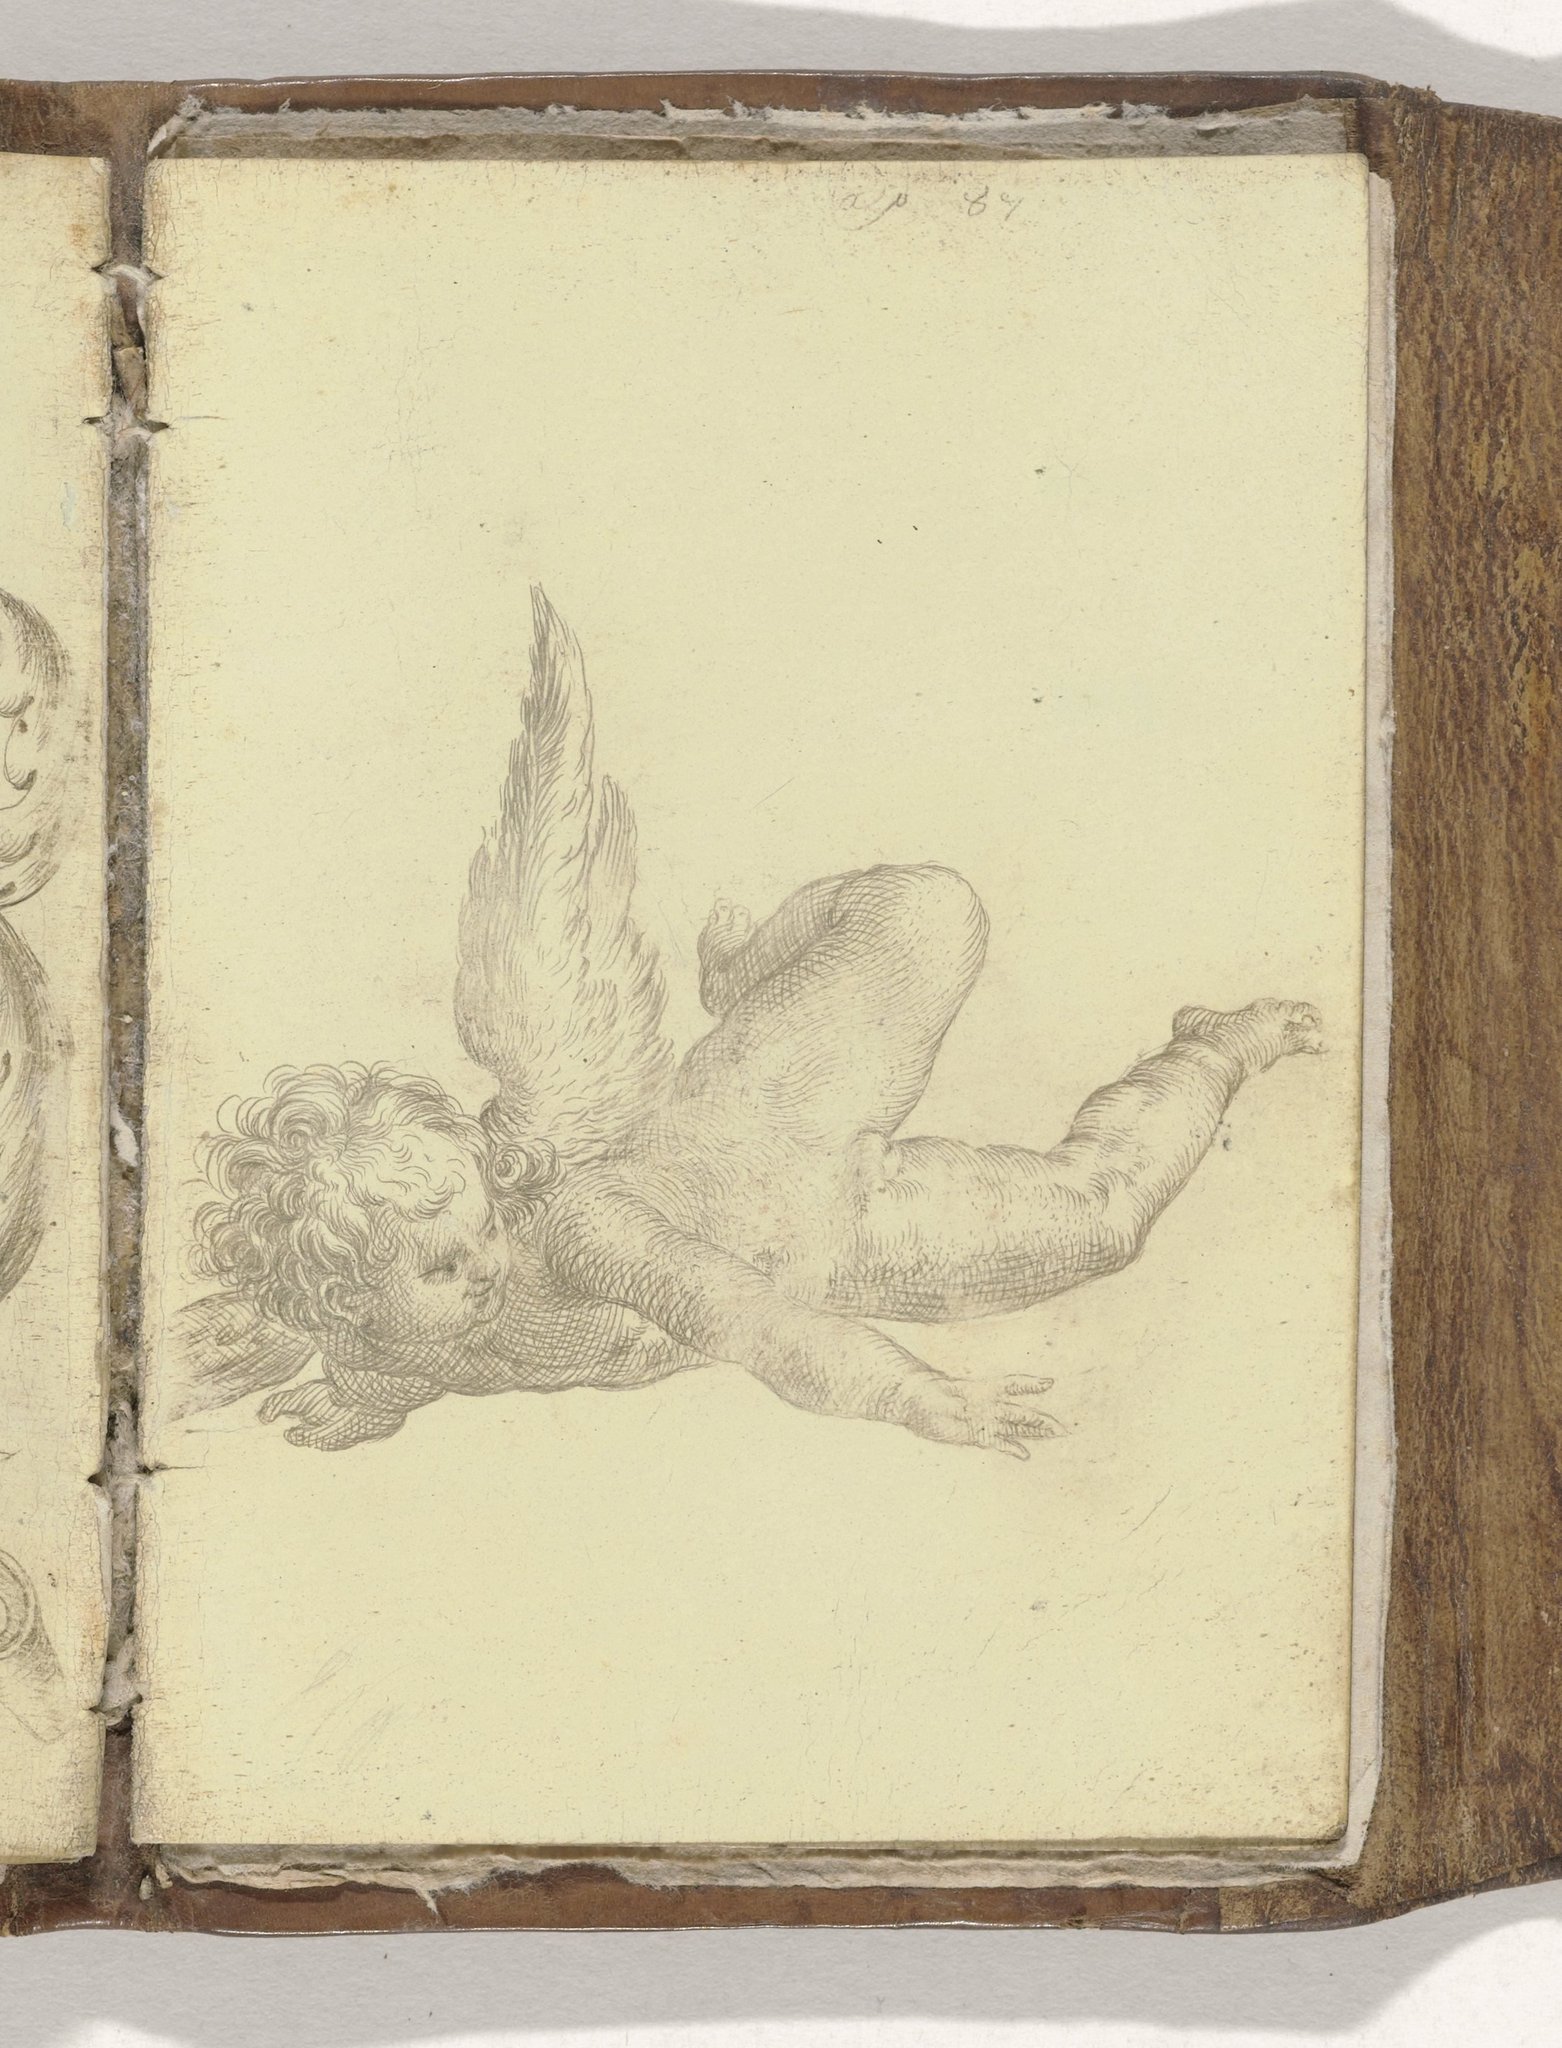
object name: metalpoint drawing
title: Schetsboek "A.S.Fe", 1587, blad 11r(12)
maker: Anonymous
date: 1587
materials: paper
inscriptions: date